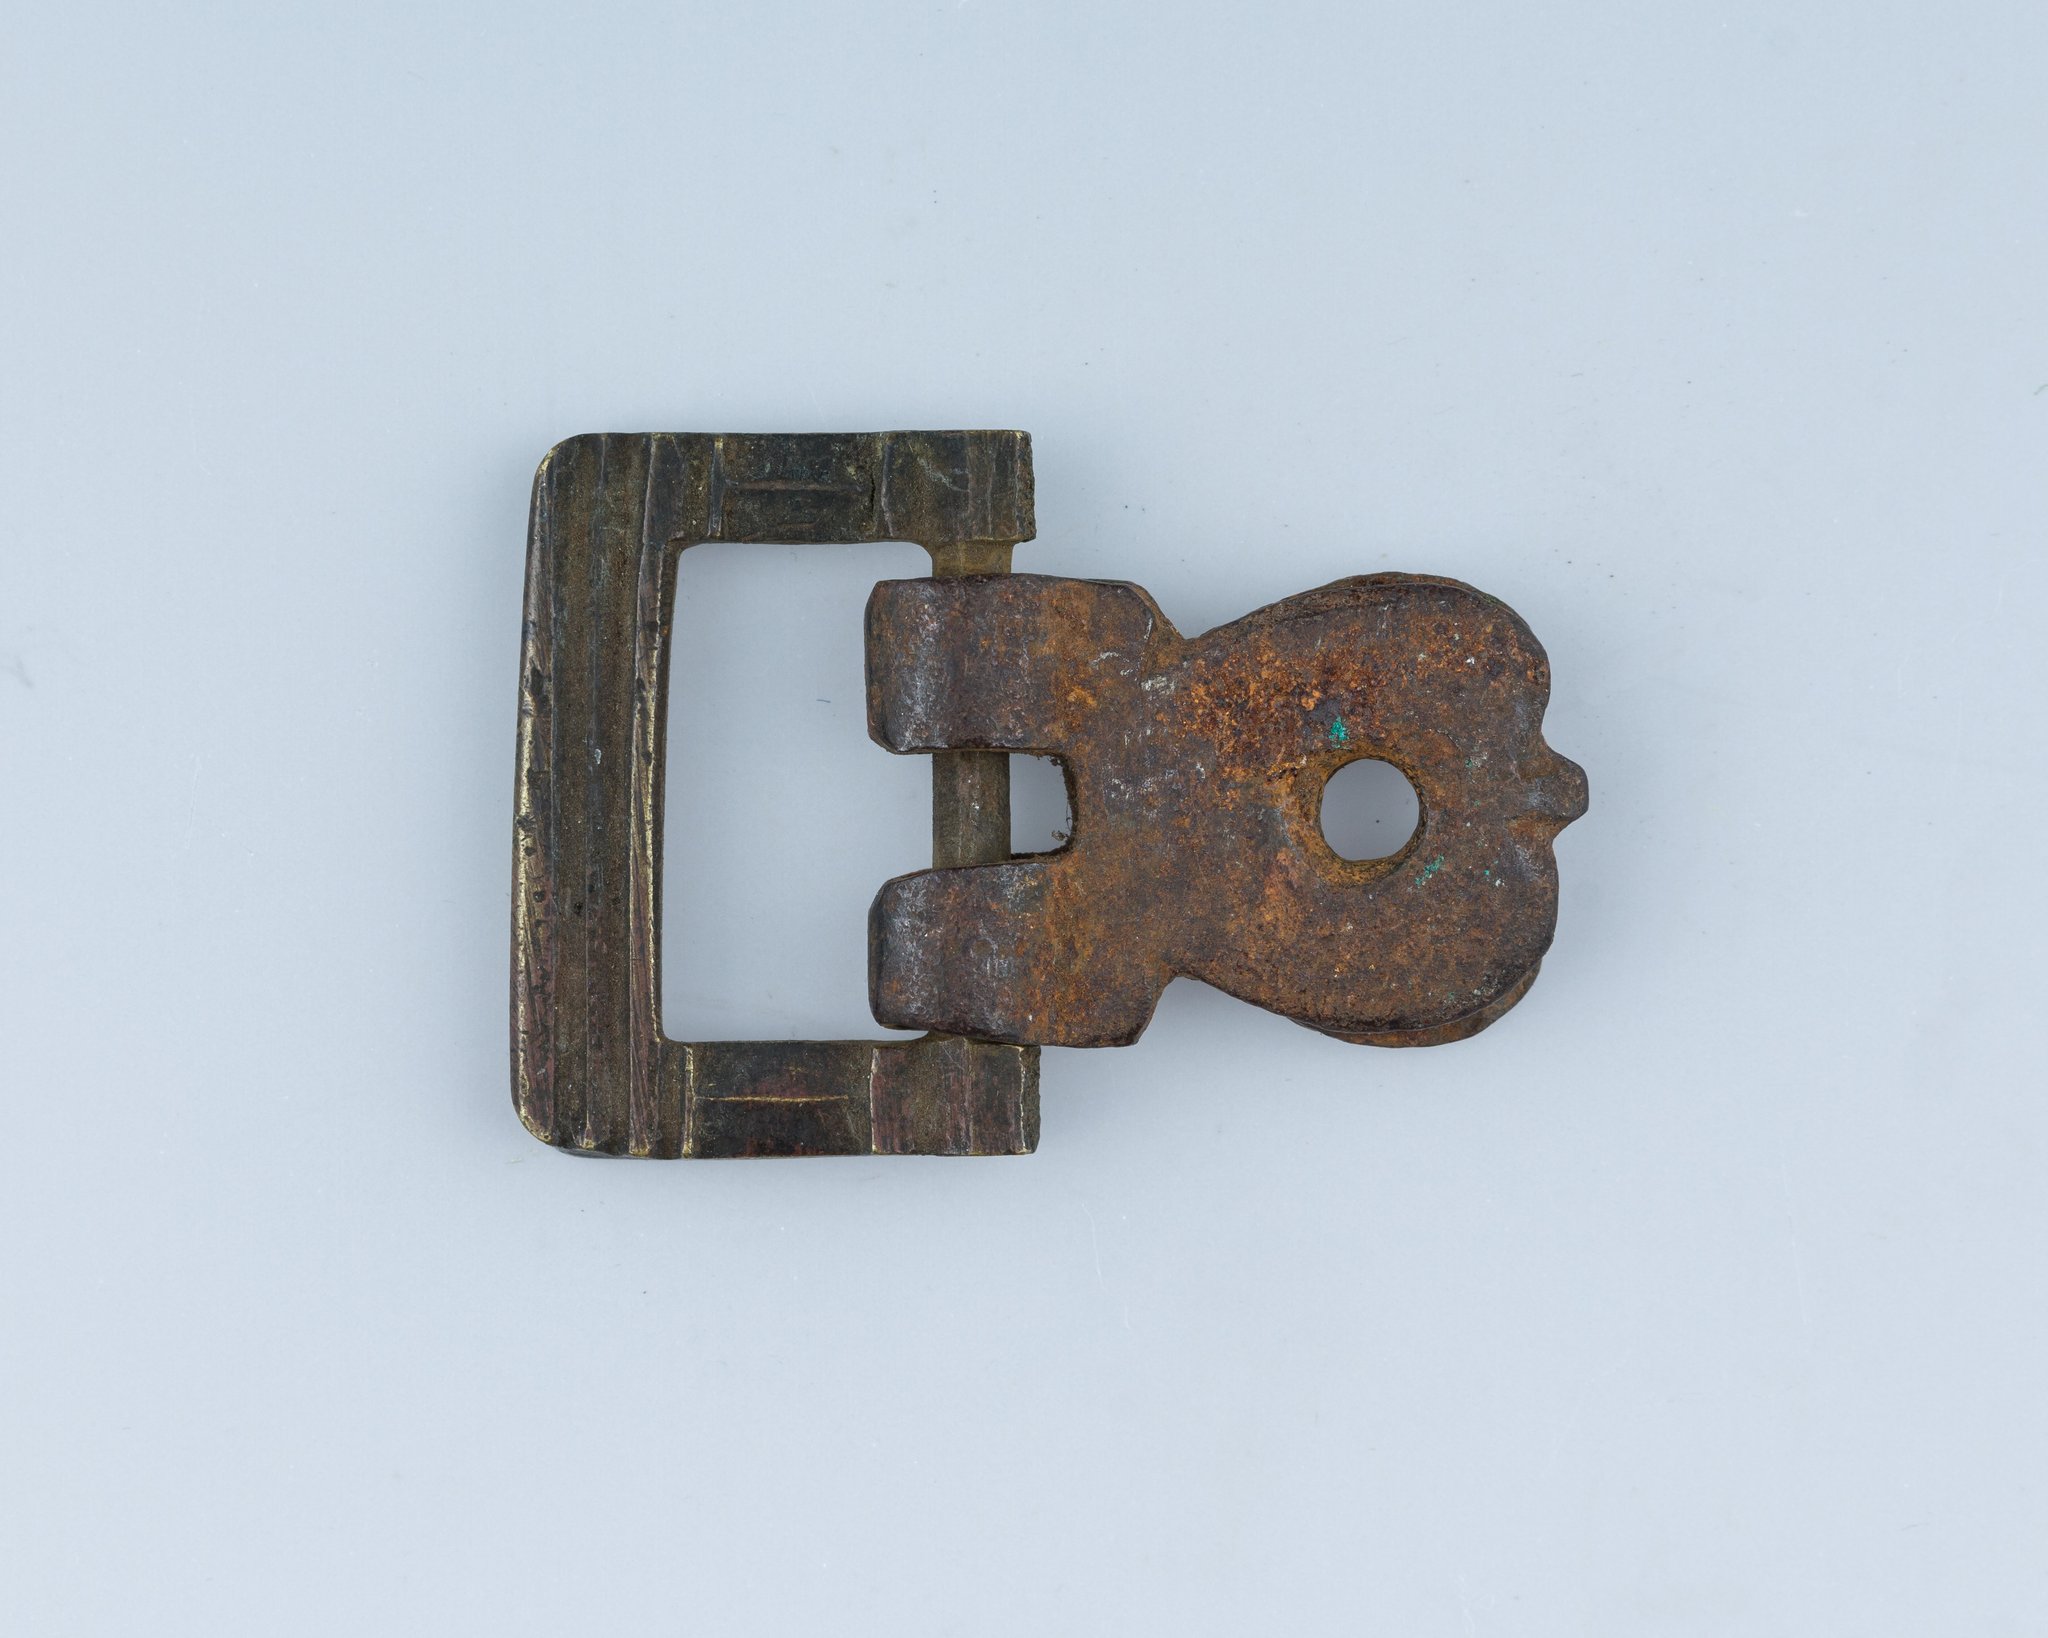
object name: buckle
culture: german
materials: steel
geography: germany